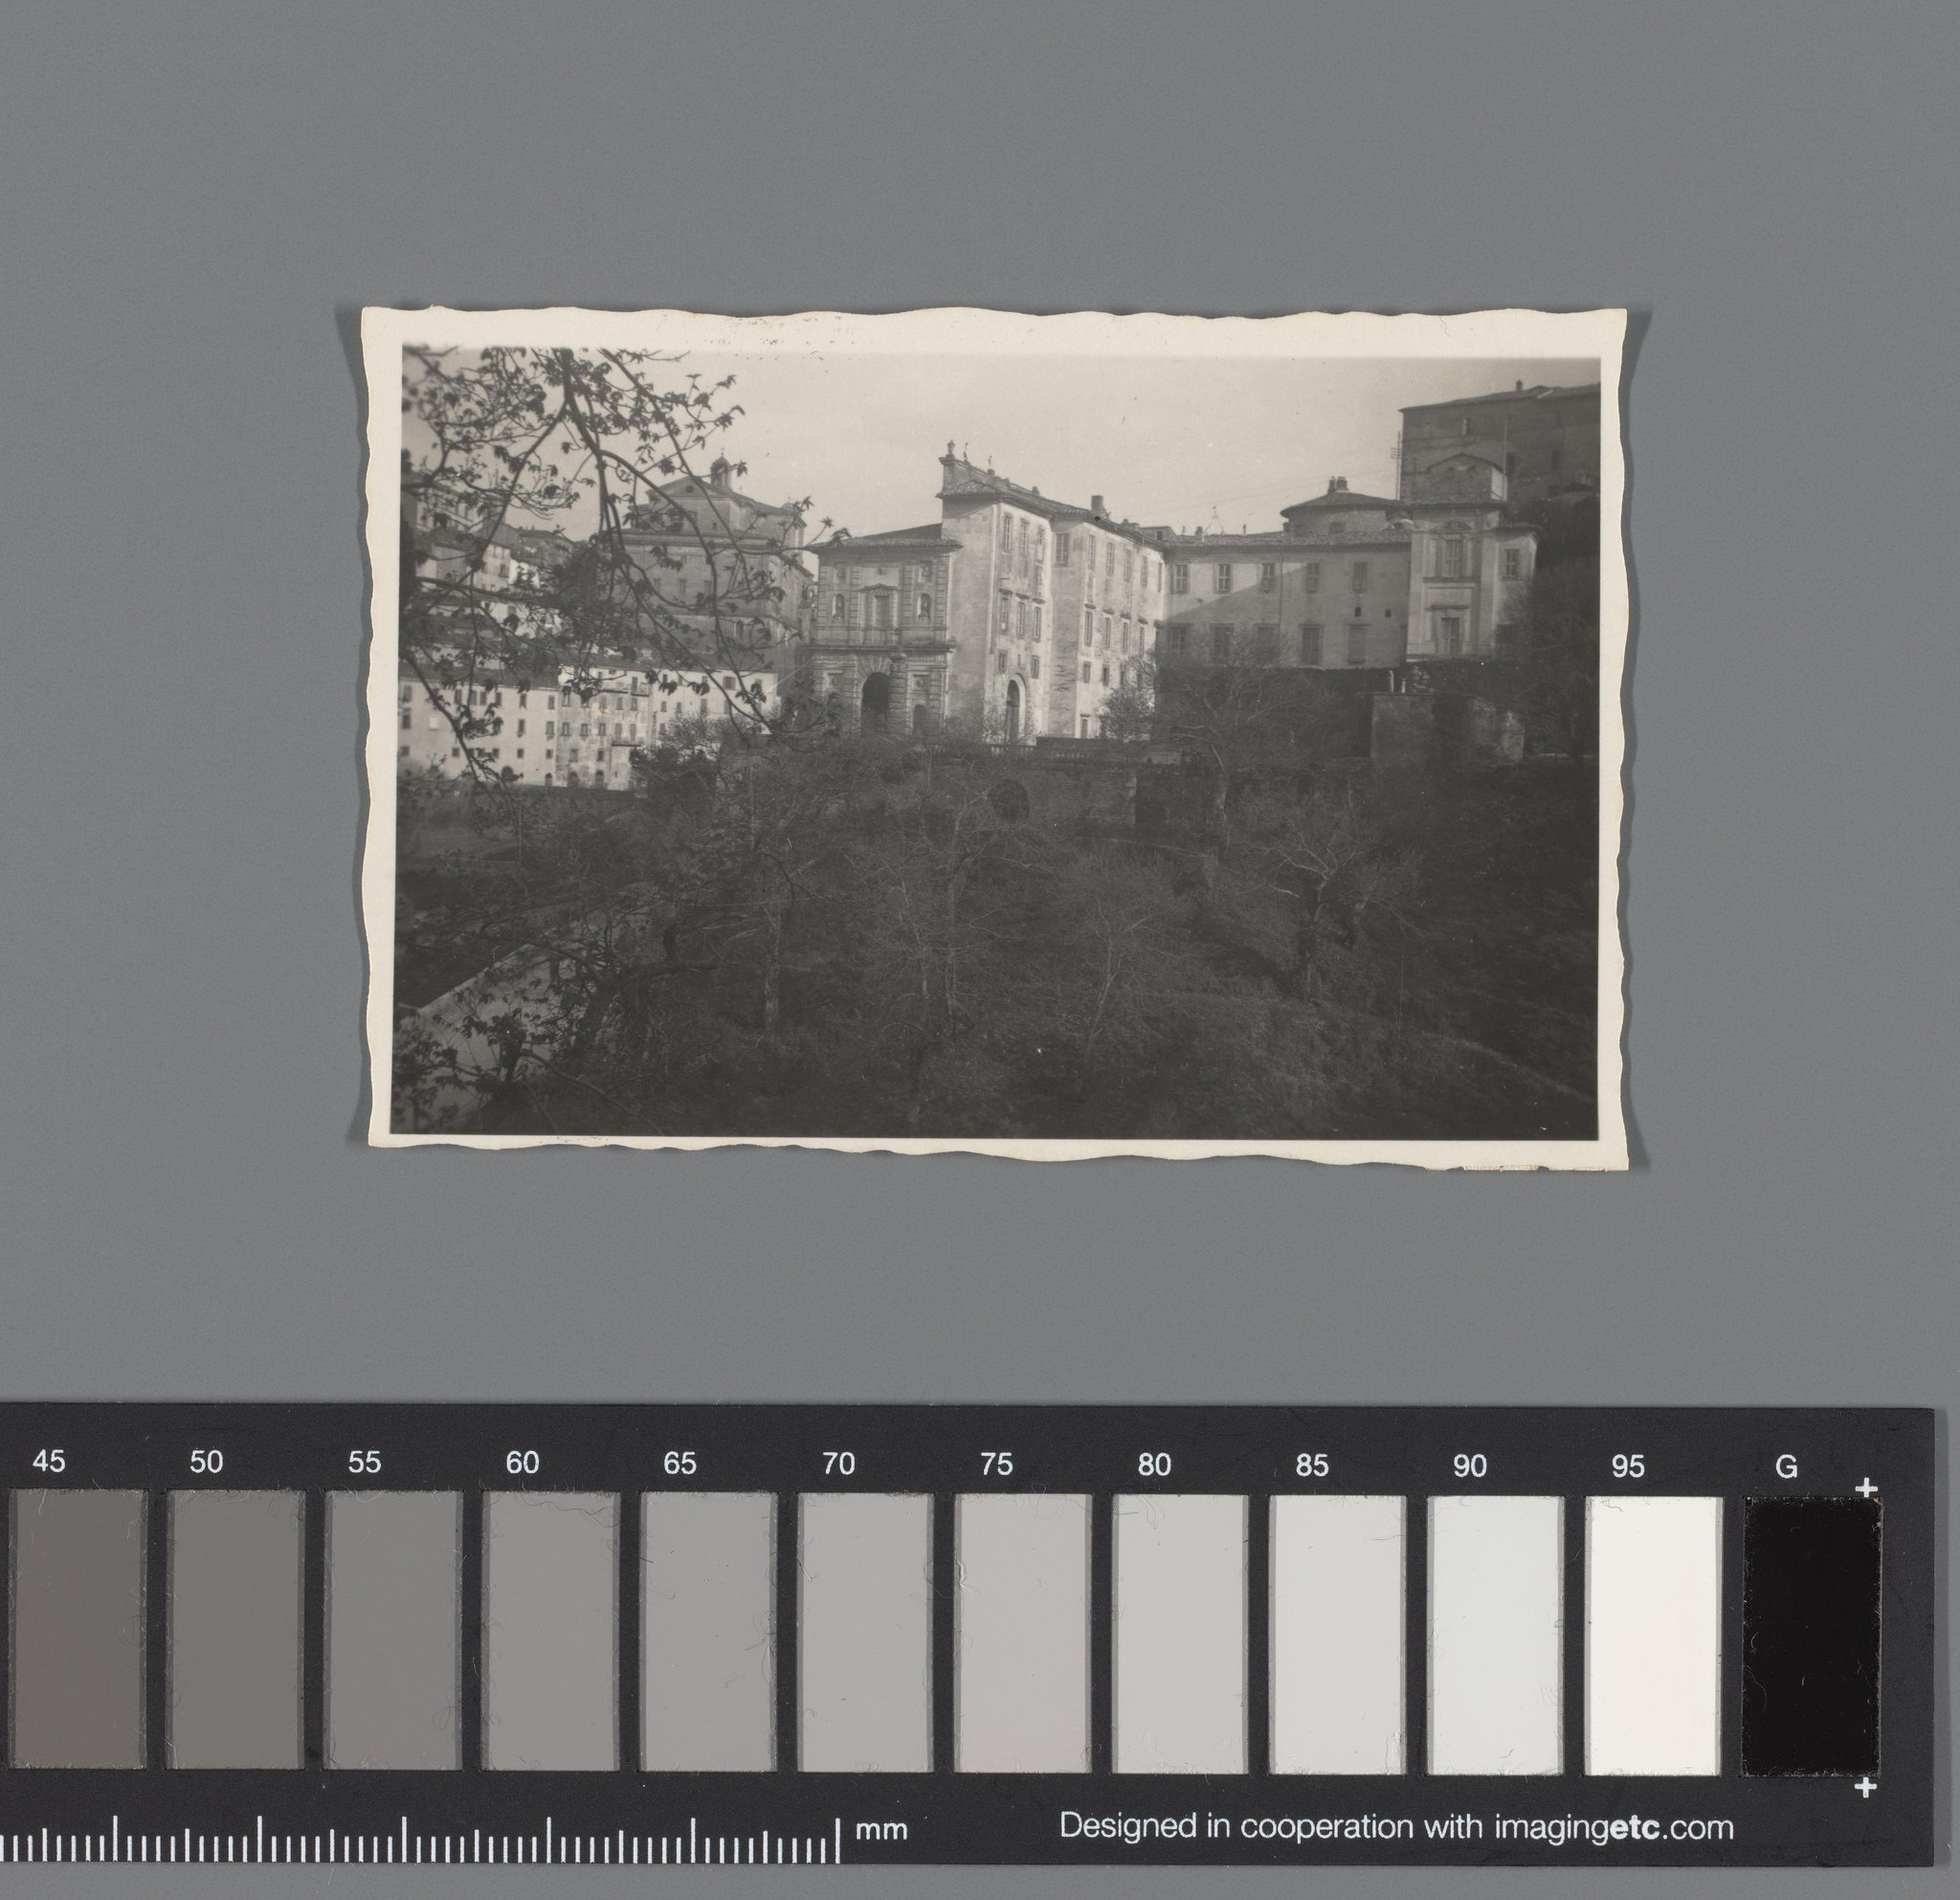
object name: photograph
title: Pcl. Chigi gli Albani a soriano del Cimino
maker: Anonymous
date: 1885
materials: photographic support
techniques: gelatin silver print